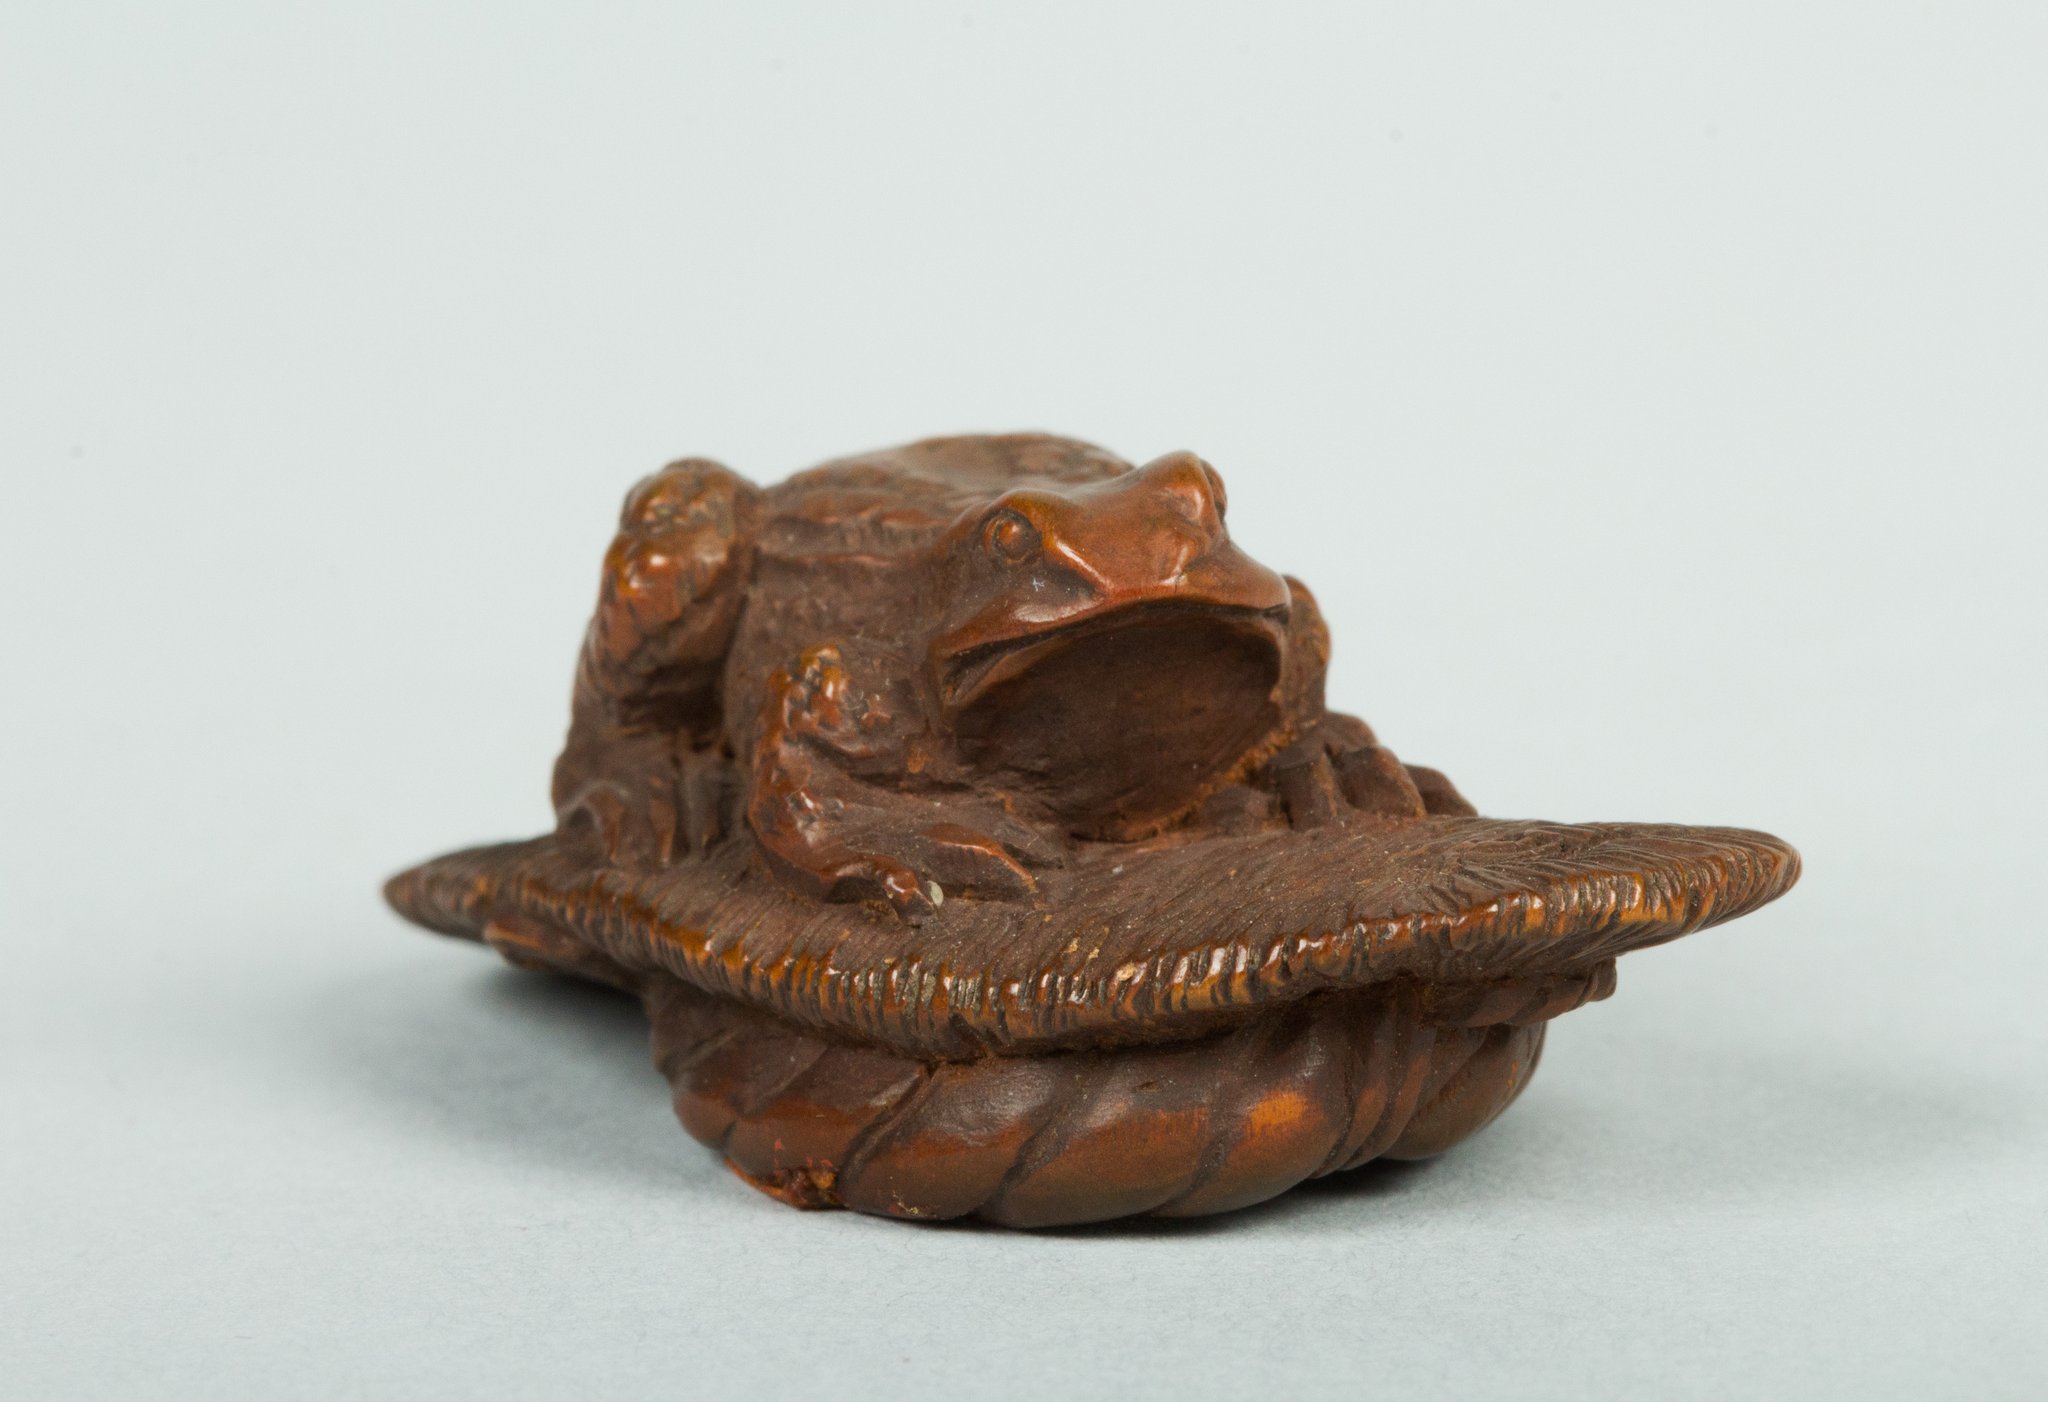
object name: netsuke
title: Netsuke of Toad on a Sandal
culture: japanese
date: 1701-1800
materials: wood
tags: frogs